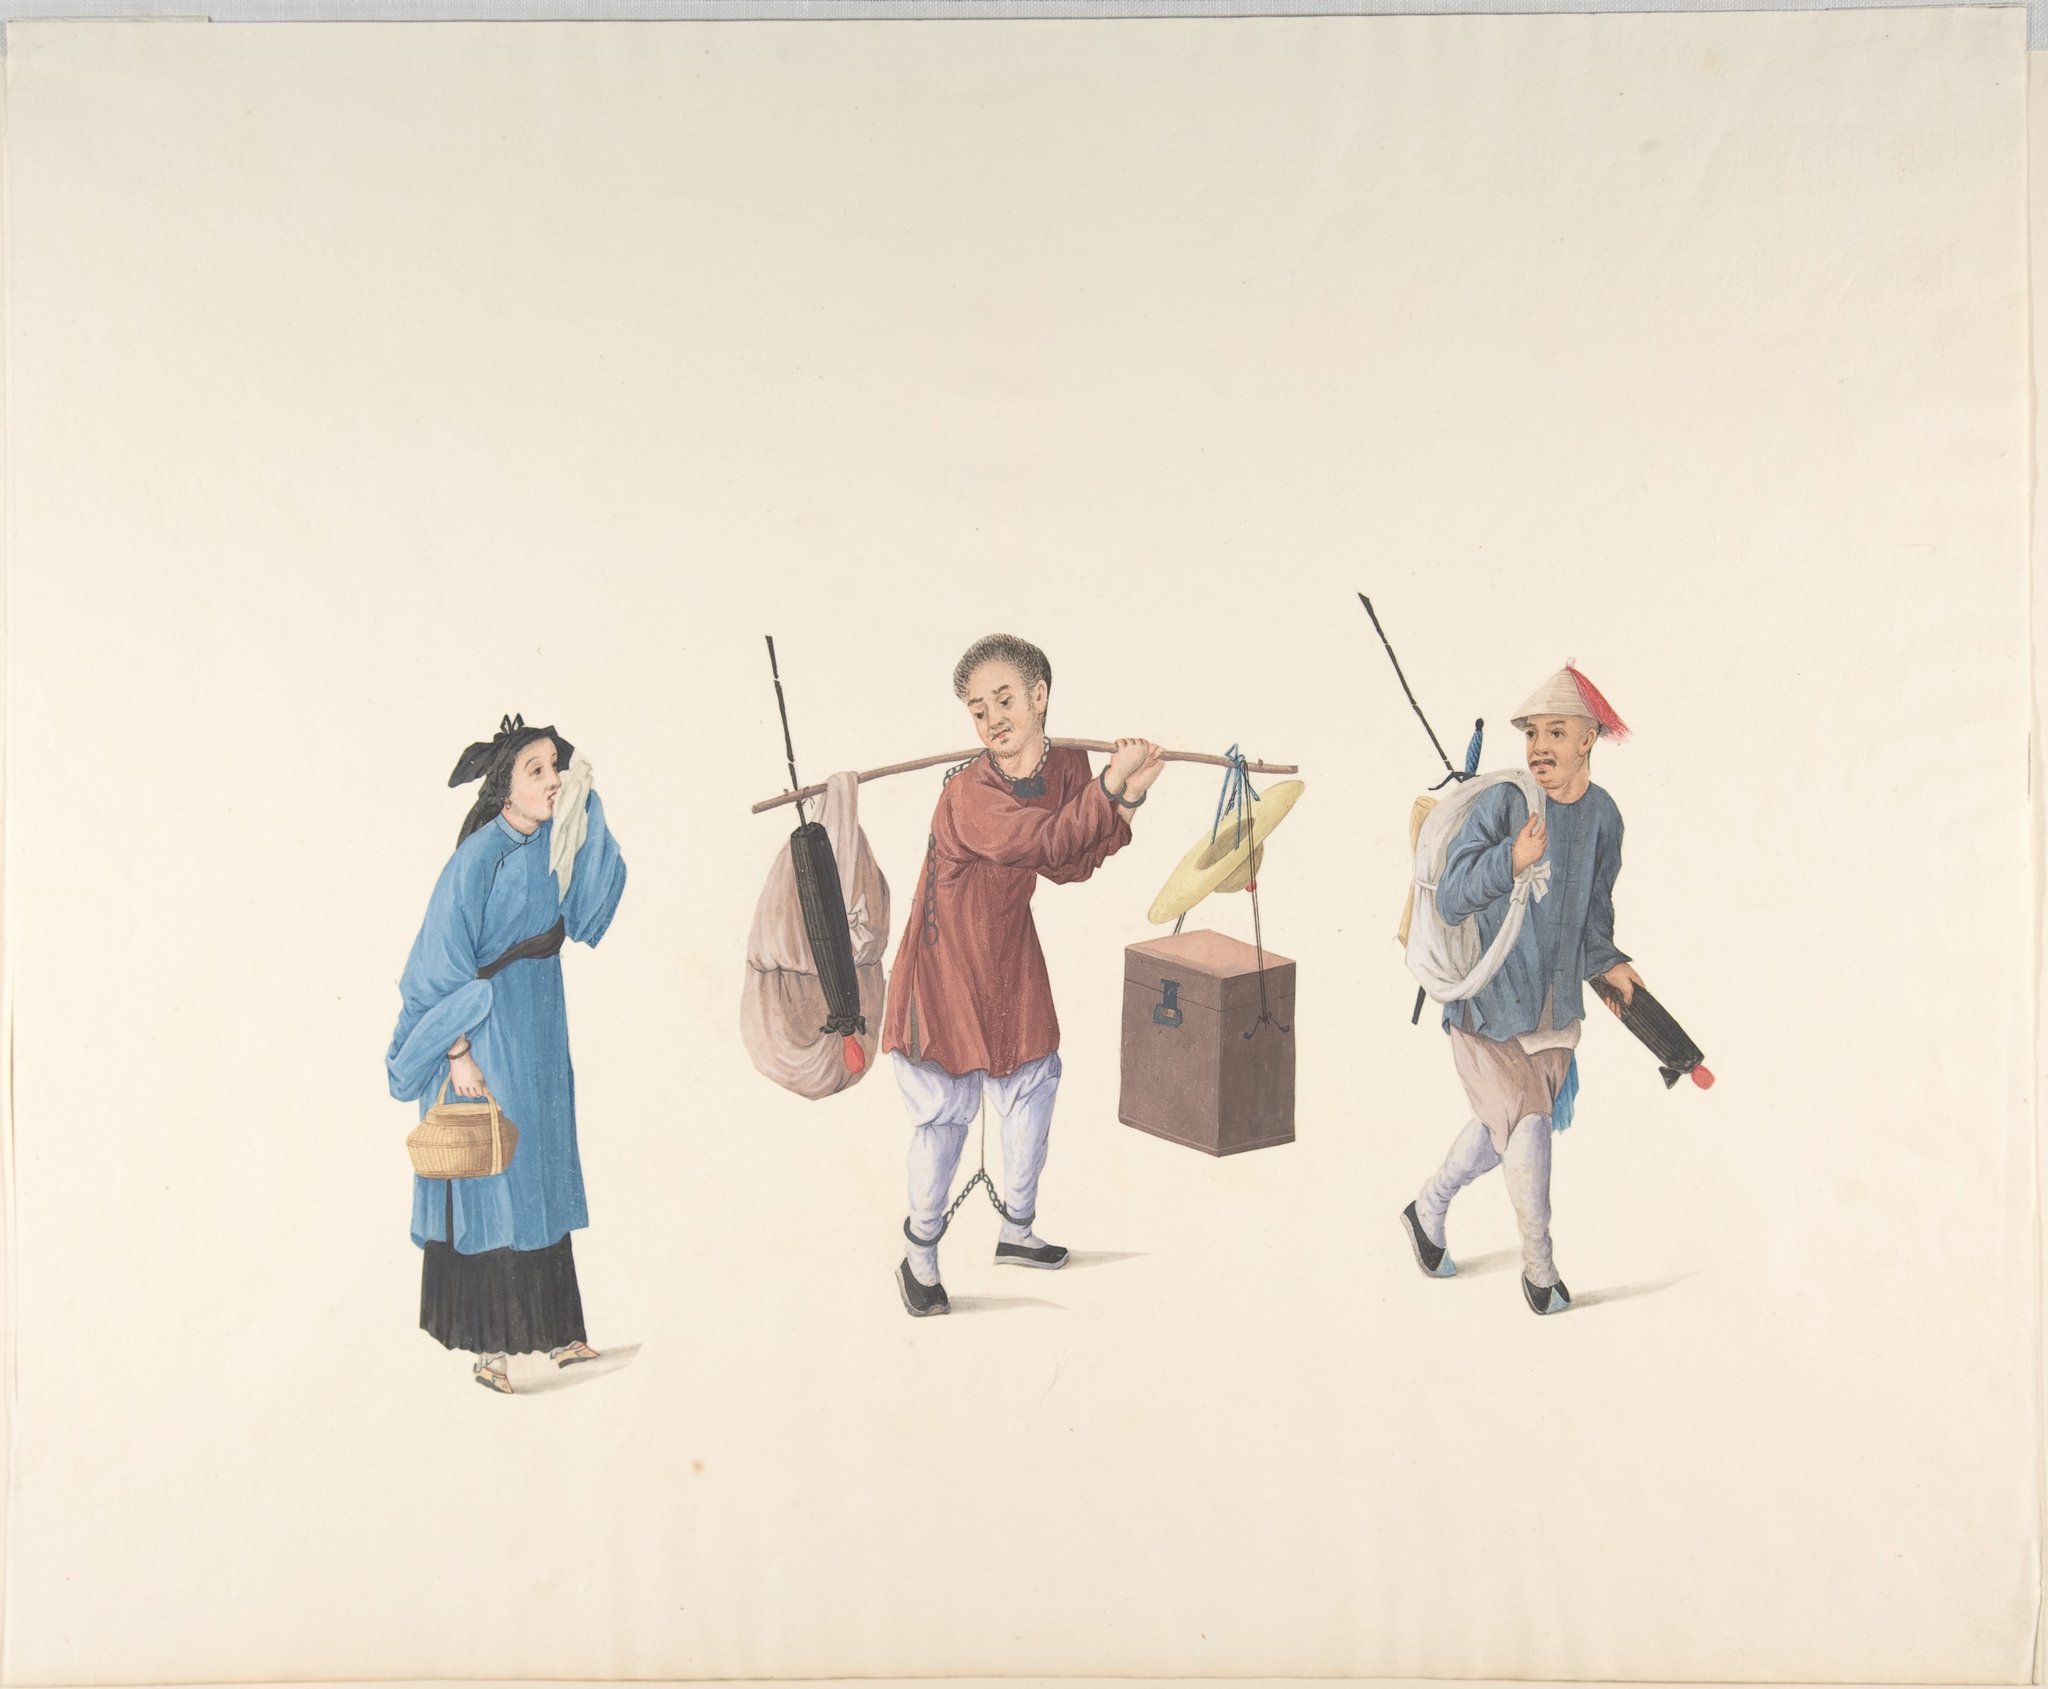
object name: drawing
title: Chinese Woman, Man with Legs Chained and Another Carrying Parasol and Bundle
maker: anonymous, chinese, 19th century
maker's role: artist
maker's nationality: chinese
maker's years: 1800-1900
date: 1801-1900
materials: gouache, watercolor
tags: men,women